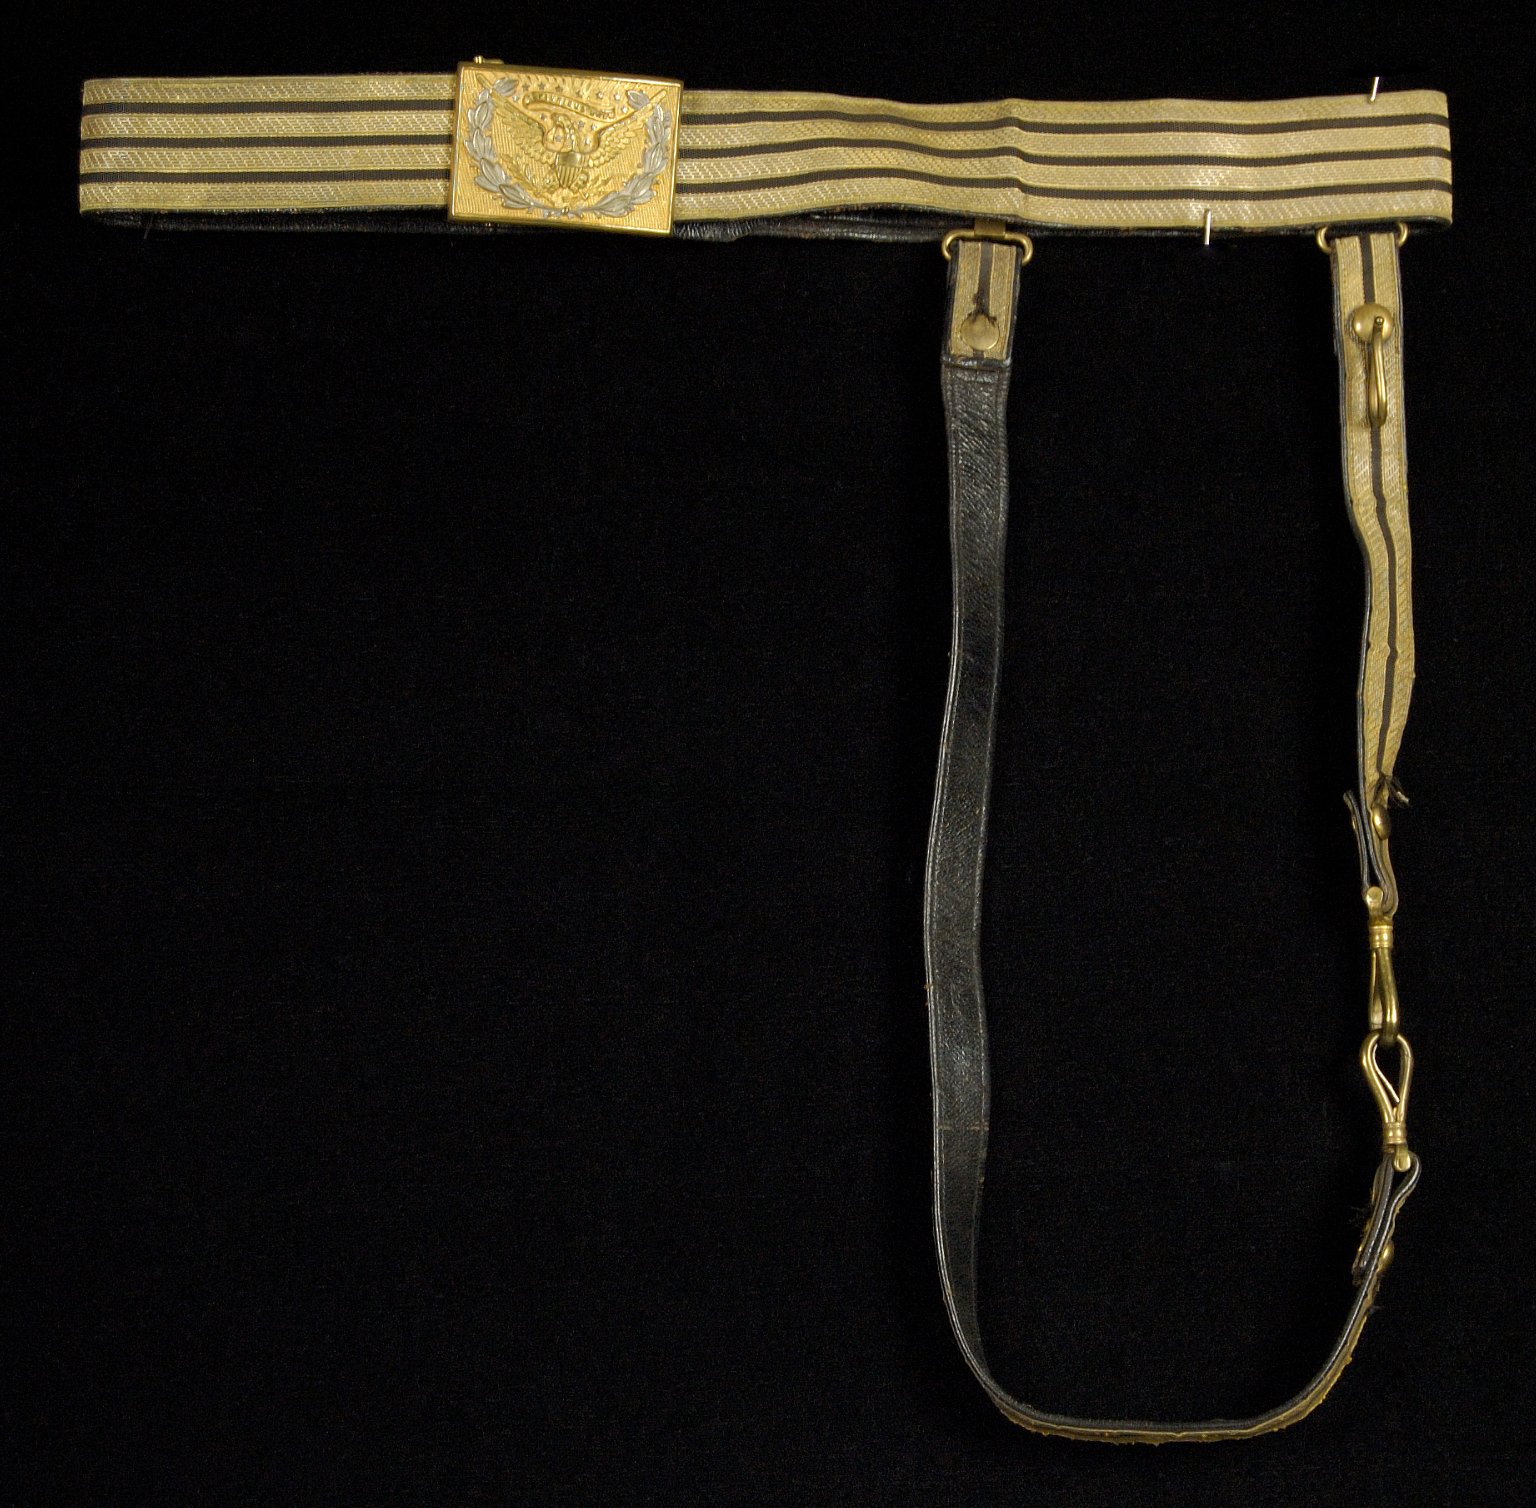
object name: military belt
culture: american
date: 1875-1880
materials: leather, metal